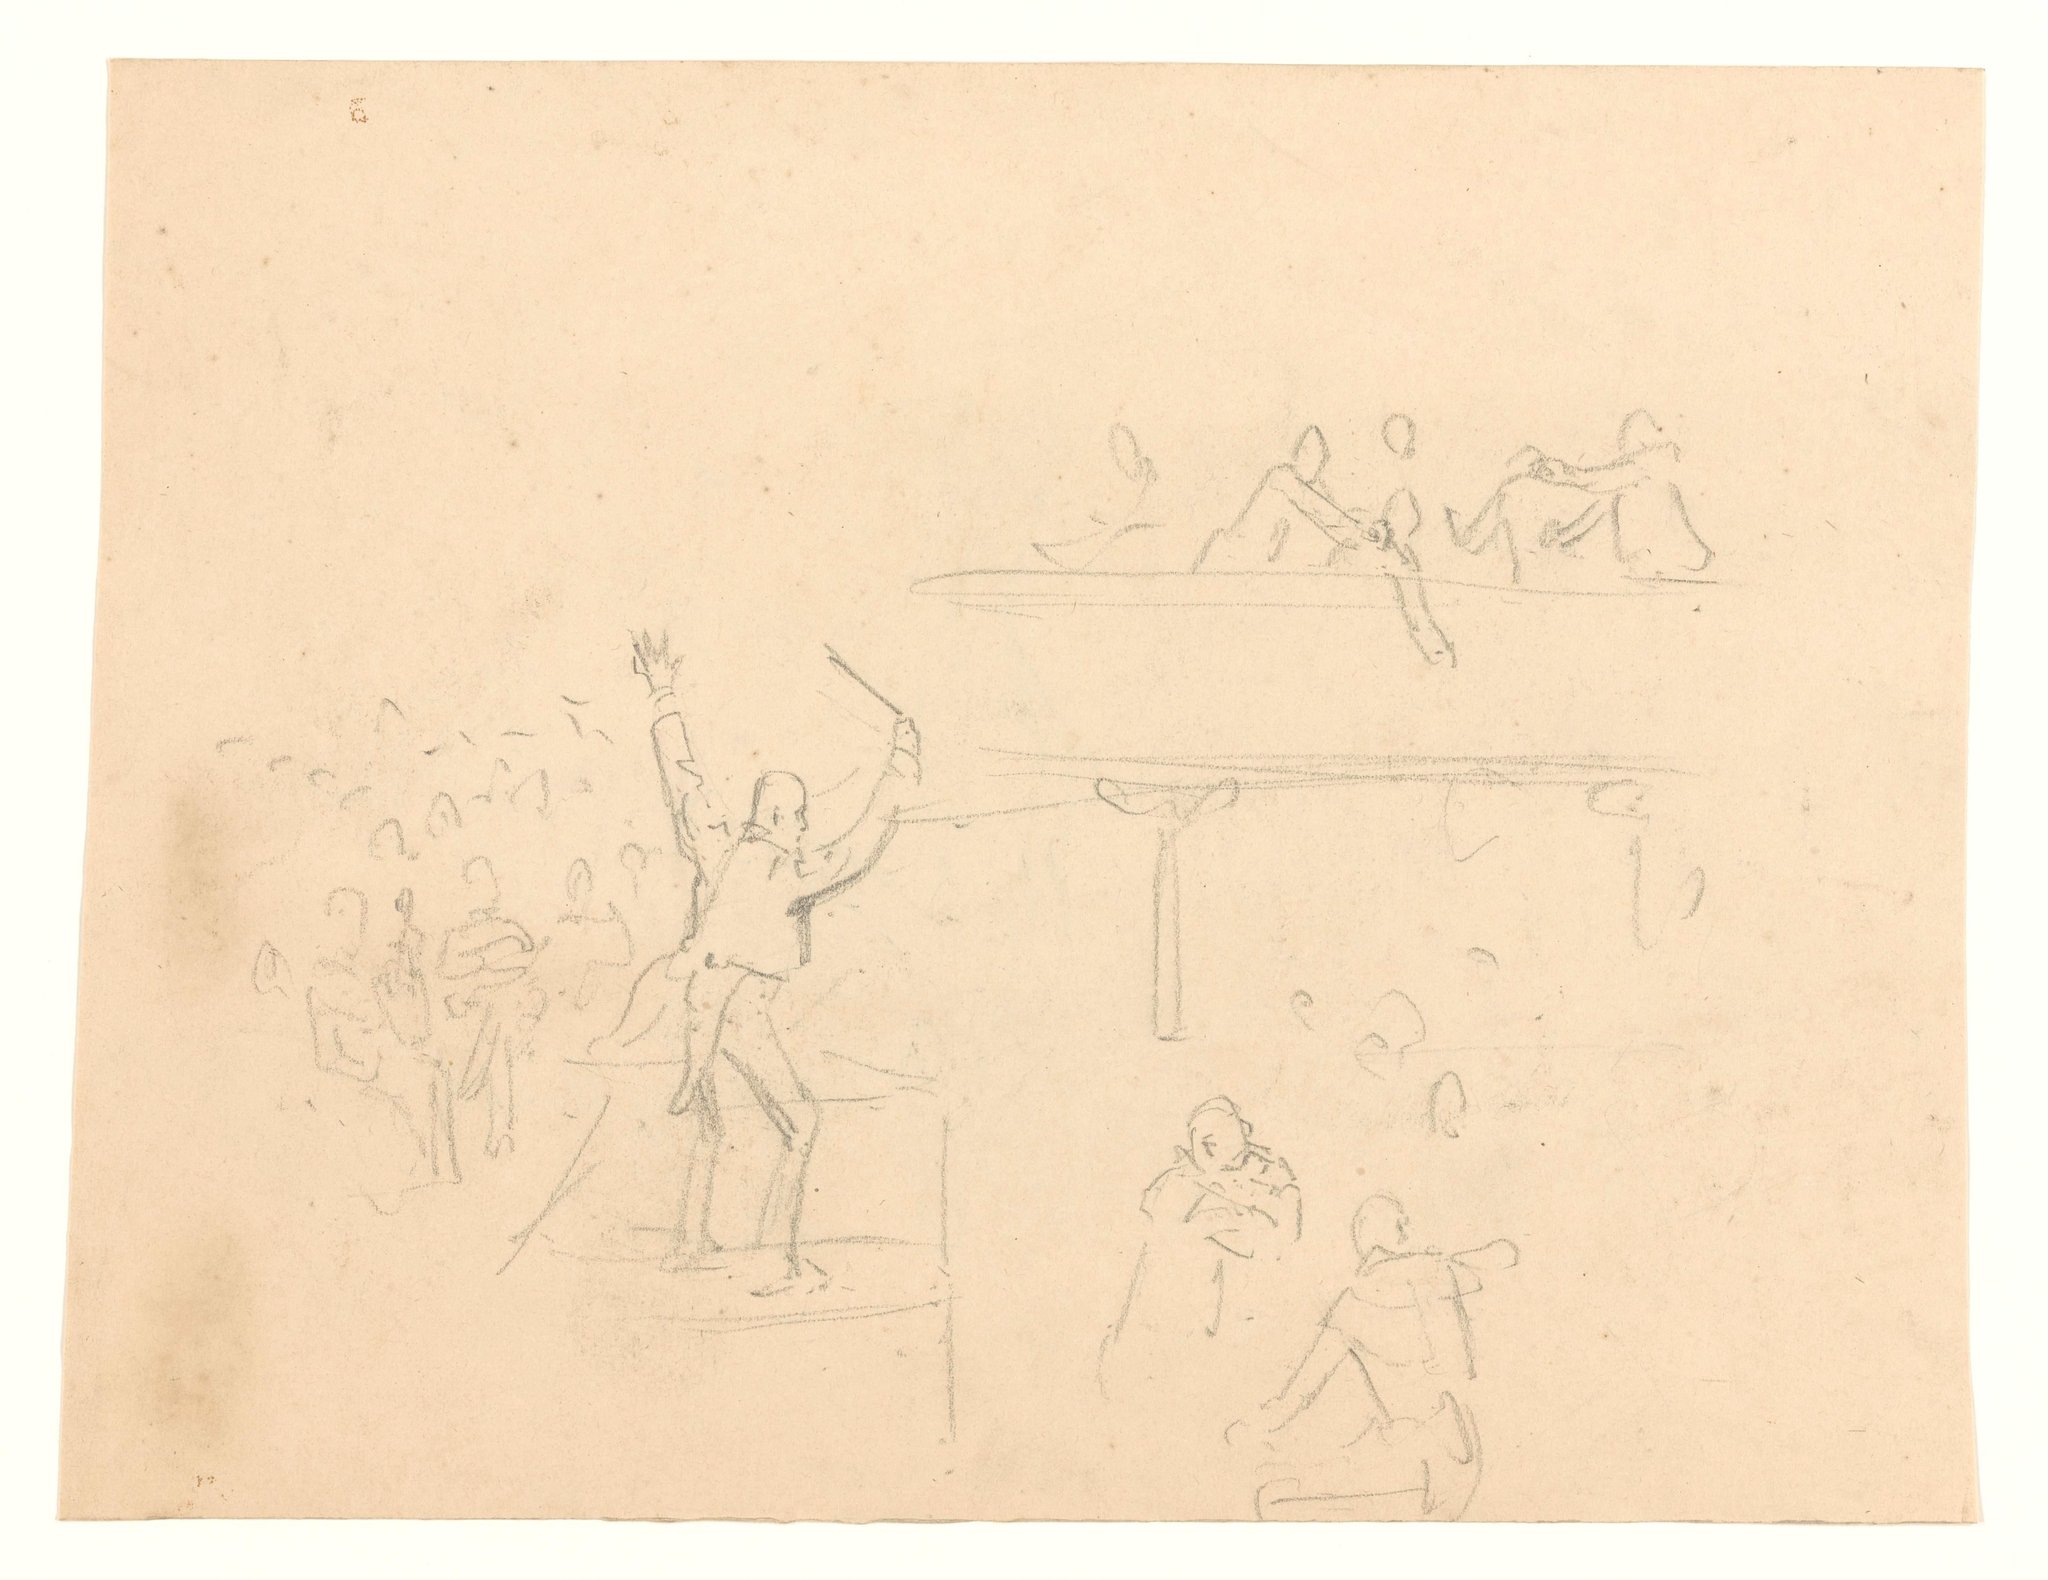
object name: design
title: Ontwerp voor illustratie in De Amsterdammer: dirigent voor een concertzaal (op de verso een staande naakte figuur) (7 December 1918)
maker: johan braakensiek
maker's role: draughtsman, print maker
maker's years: 1858-1940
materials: chalk, paper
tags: historical events and situations, political caricatures and satires